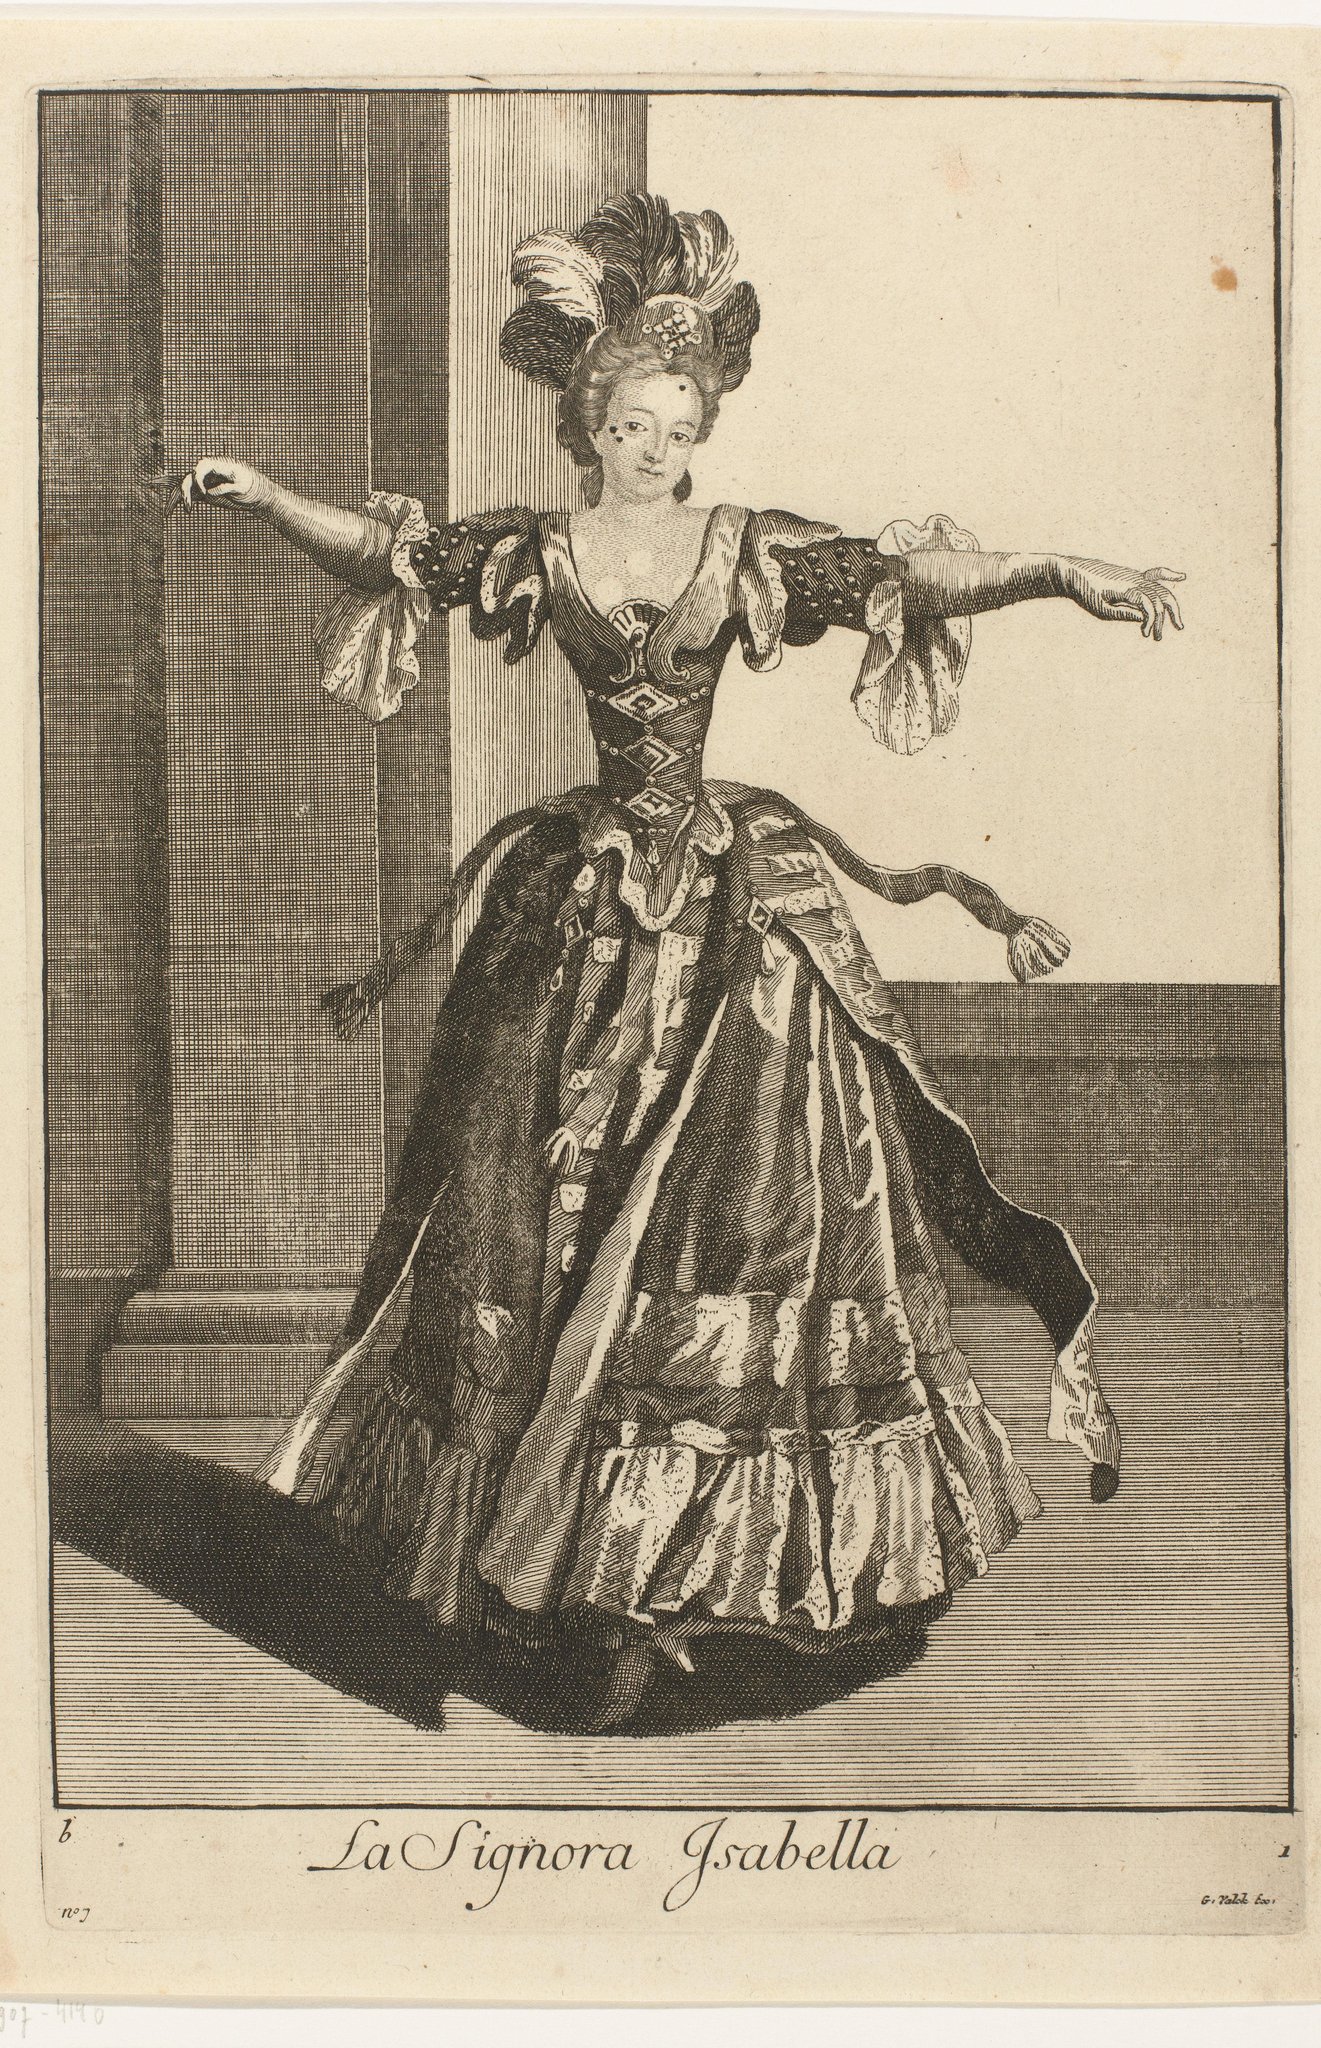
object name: costume print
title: La Signora Isabella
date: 1694-1715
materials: paper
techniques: engraving, etching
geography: amsterdam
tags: woman dancing alone, dress, gown (+ women's clothes)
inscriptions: collector's mark: Lugt 2228